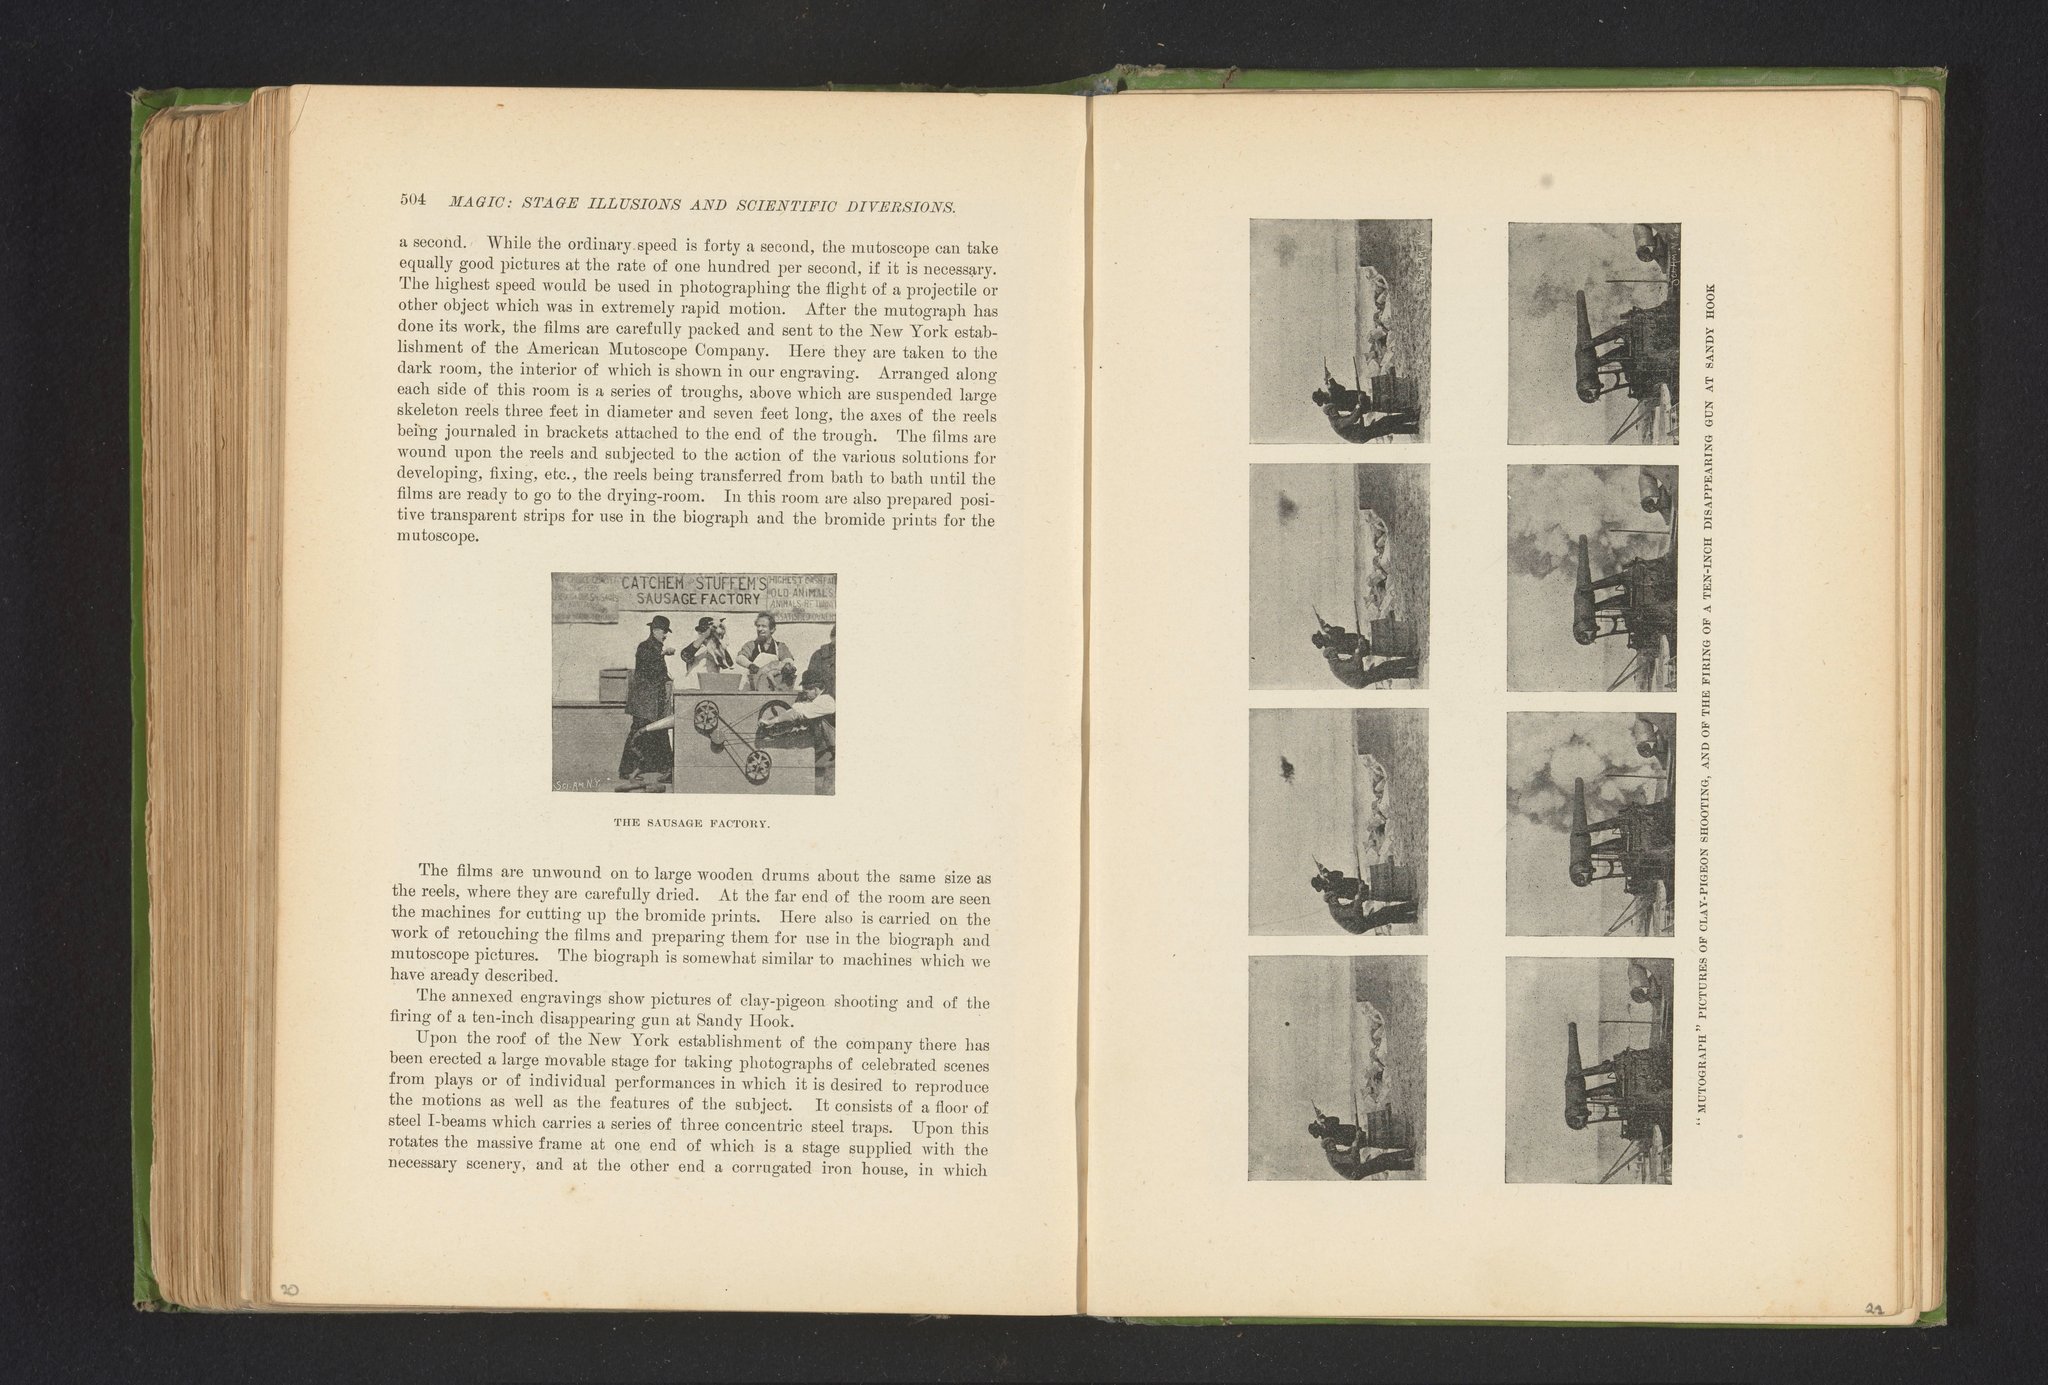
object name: photomechanical print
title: Twee series foto's geproduceerd met een "Mutograph", met daarop afgebeeld twee mannen die kleiduifschieten en het afschieten van een kanon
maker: Anonymous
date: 1892-1897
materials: paper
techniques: autotype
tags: firearms: rifle, firearms: cannon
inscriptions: inscription: ‘SCI. AM. N.Y.’